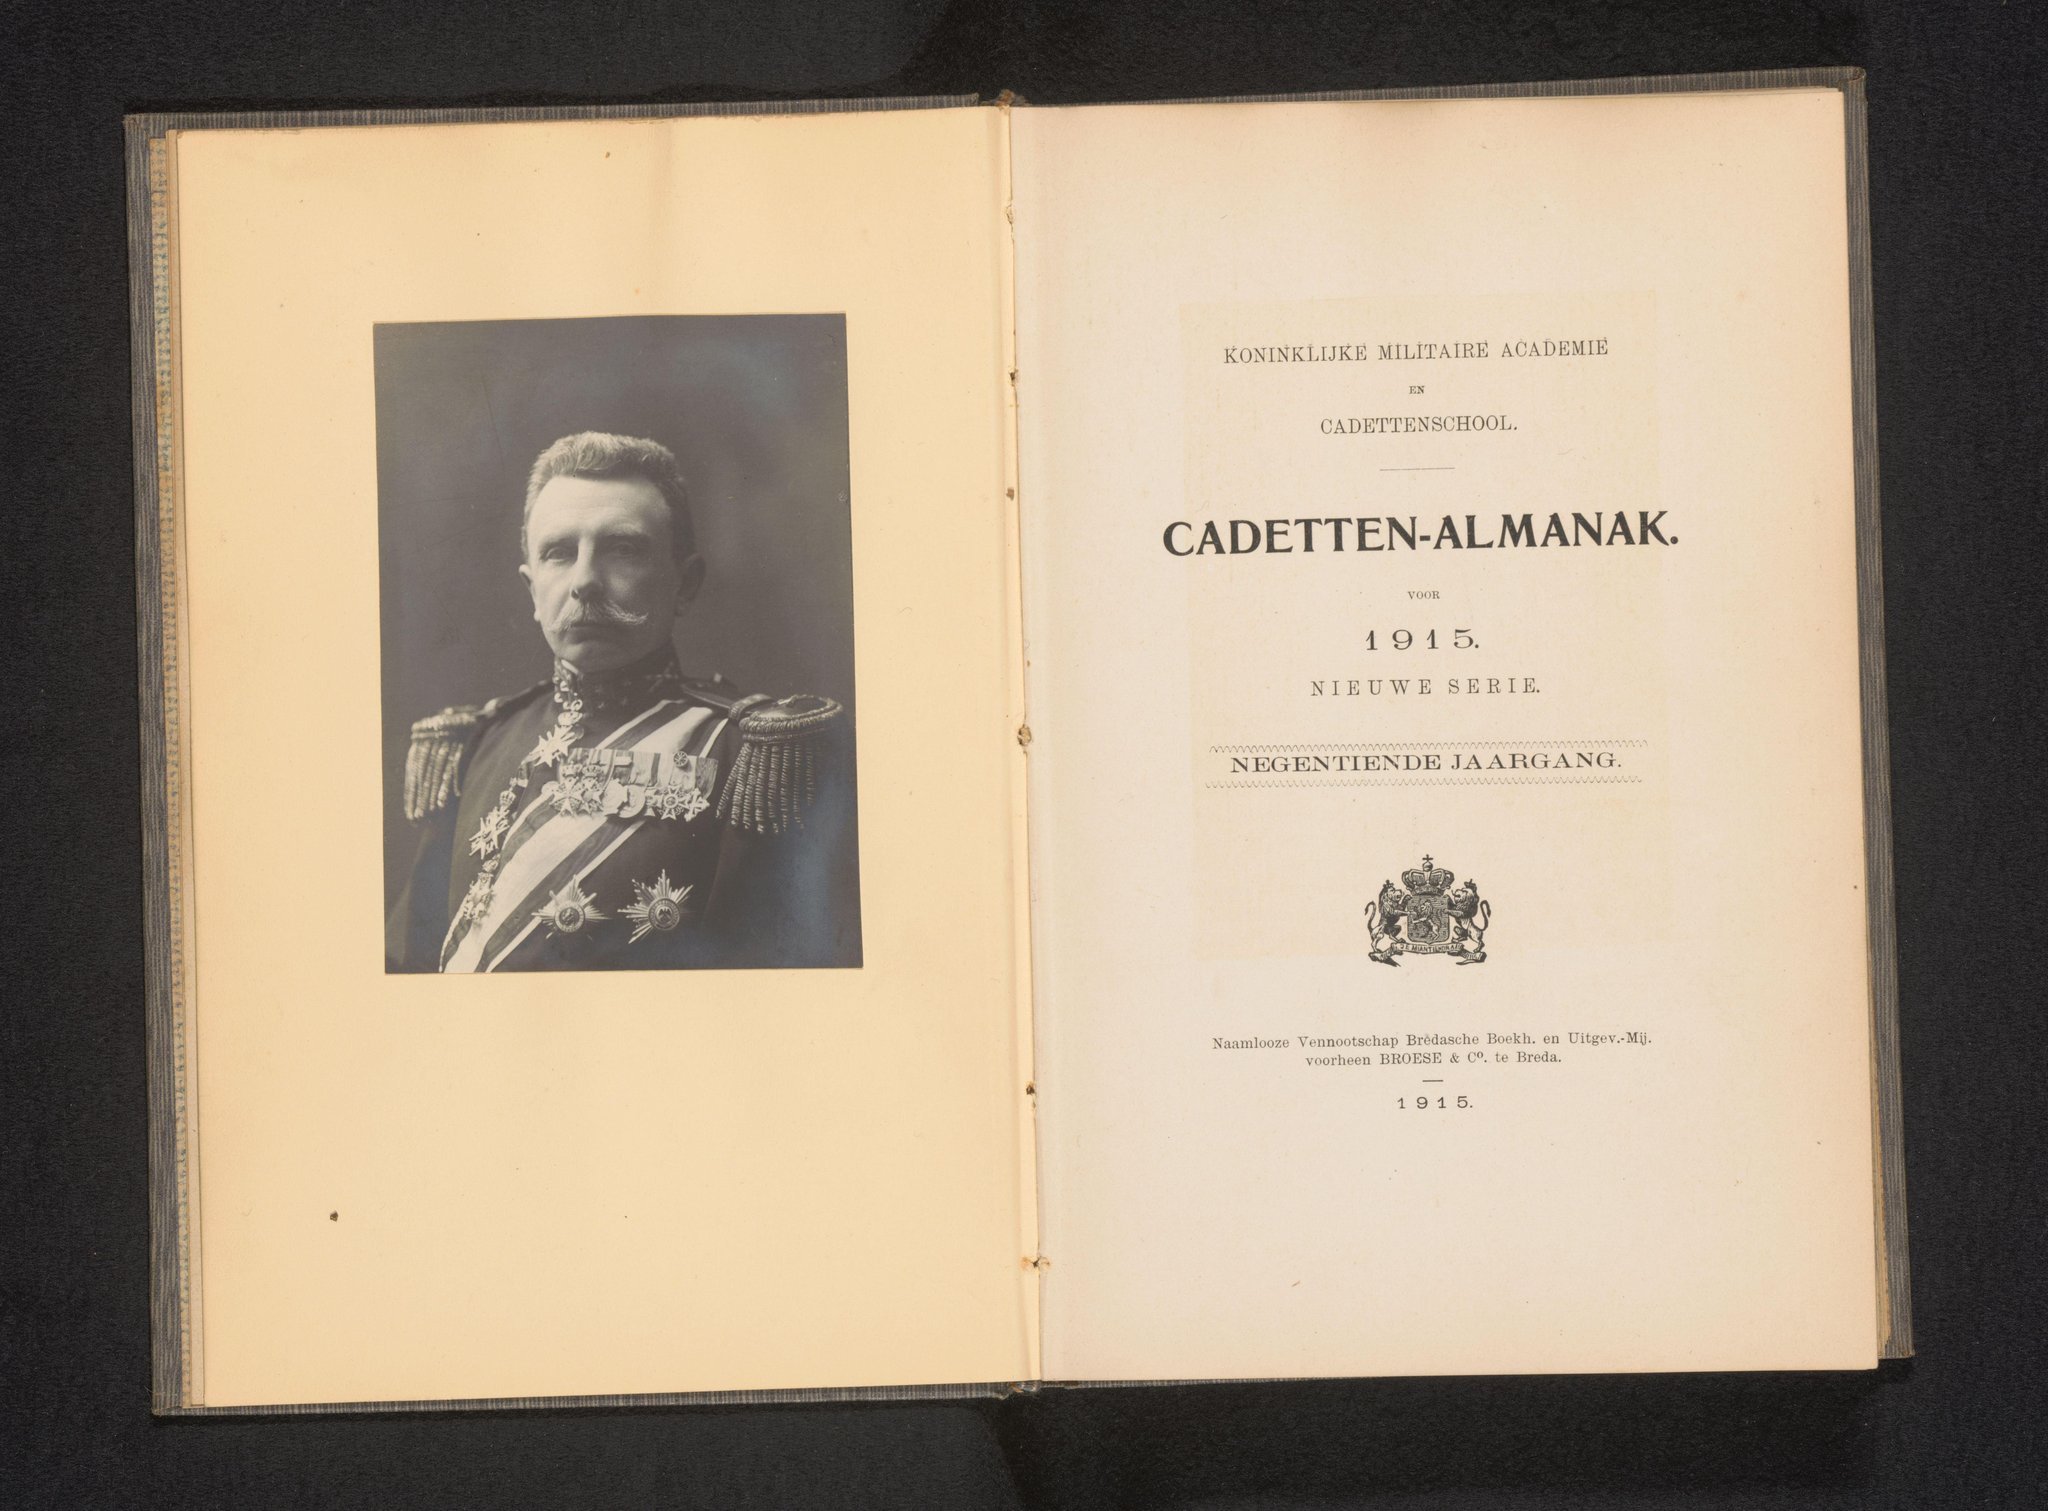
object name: page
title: Portret van een onbekende hooggeplaatste militair aan de Koninklijke Militaire Academie in Breda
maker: Anonymous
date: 1910-1915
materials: photographic support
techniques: gelatin silver print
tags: officer, historical persons not known by name